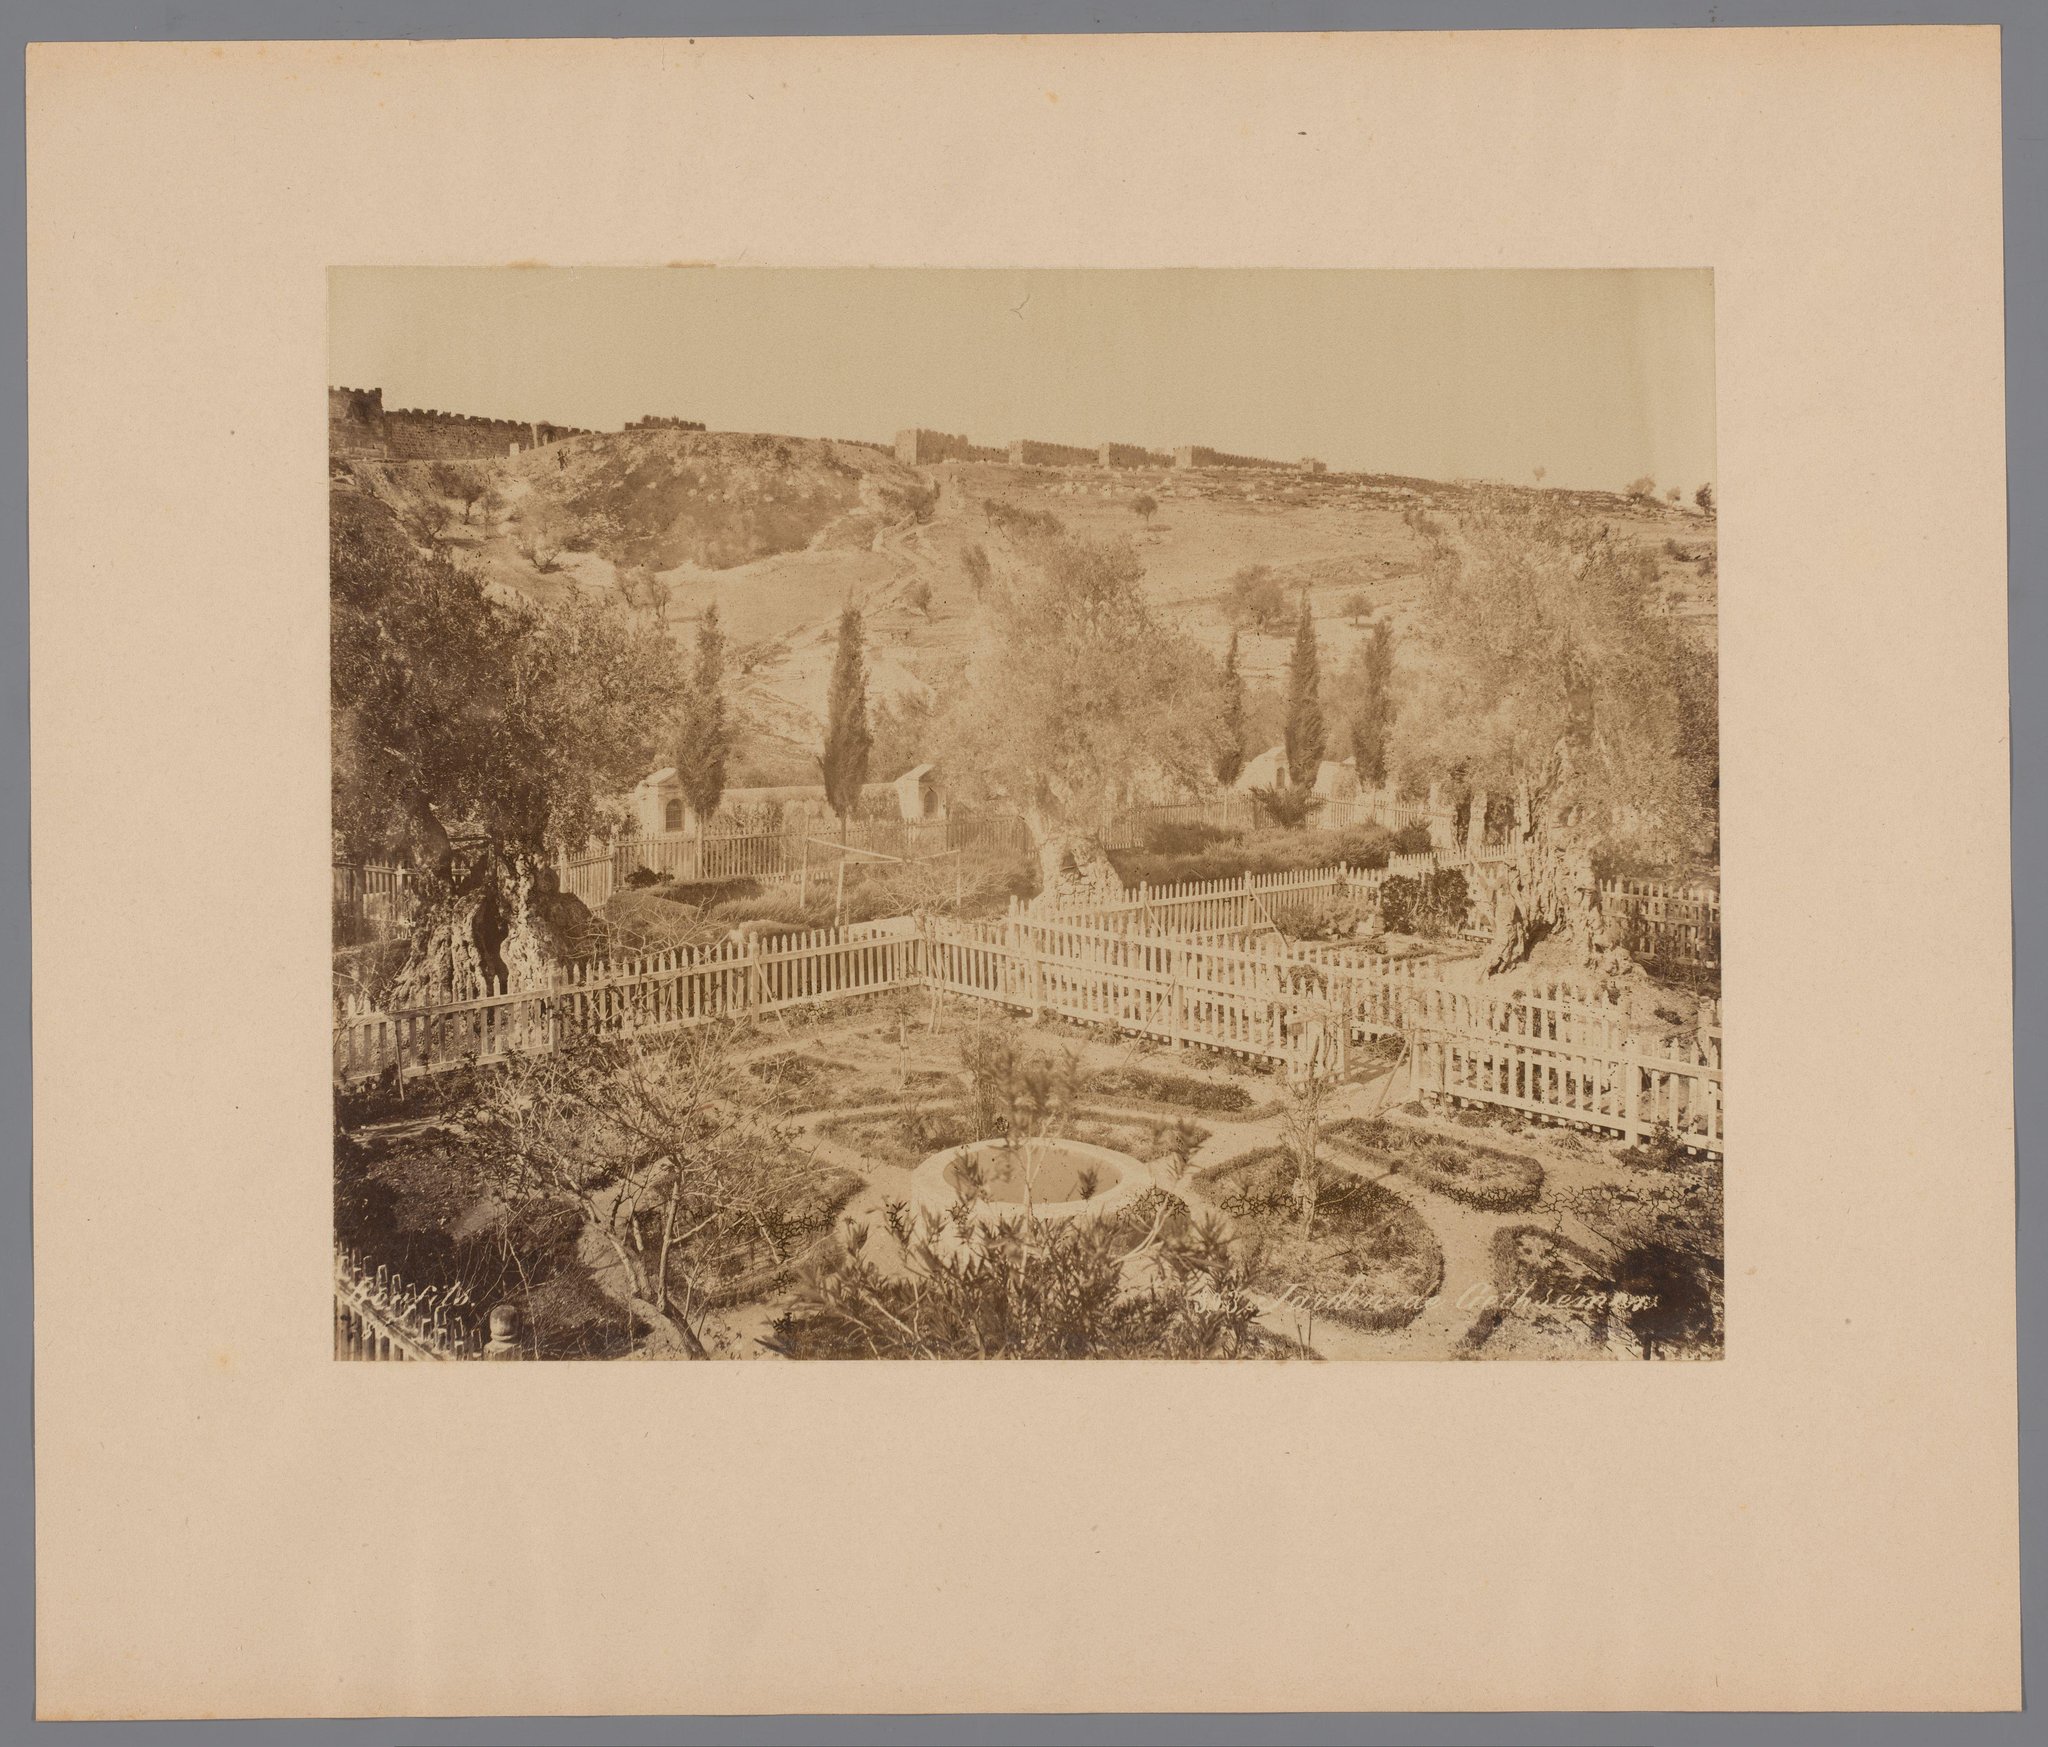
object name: photograph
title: Tuin van Getsemane, Olijfberg bij Jeruzalem, Palestina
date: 1850-1900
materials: paper, photographic support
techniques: albumen print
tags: olijfberg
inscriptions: inscription: ‘Bonfils.’, inscription: ‘303. Jardin de Géthseman’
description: De tuin of de Hof van Gethsemane [" betekent "Oliepers"] was de locatie waar Jezus volgens het Nieuwe Testament in de nacht voor zijn kruisiging een aantal uren doorbracht. Waar de hof precies lag is niet duidelijk, maar vaak wordt aangenomen dat dat op de Olijfberg was, buiten de muren van Jeruzalem, aan de overkant van de beek Kidron, waar de tuin tegenwoordig is gelocaliseerd.